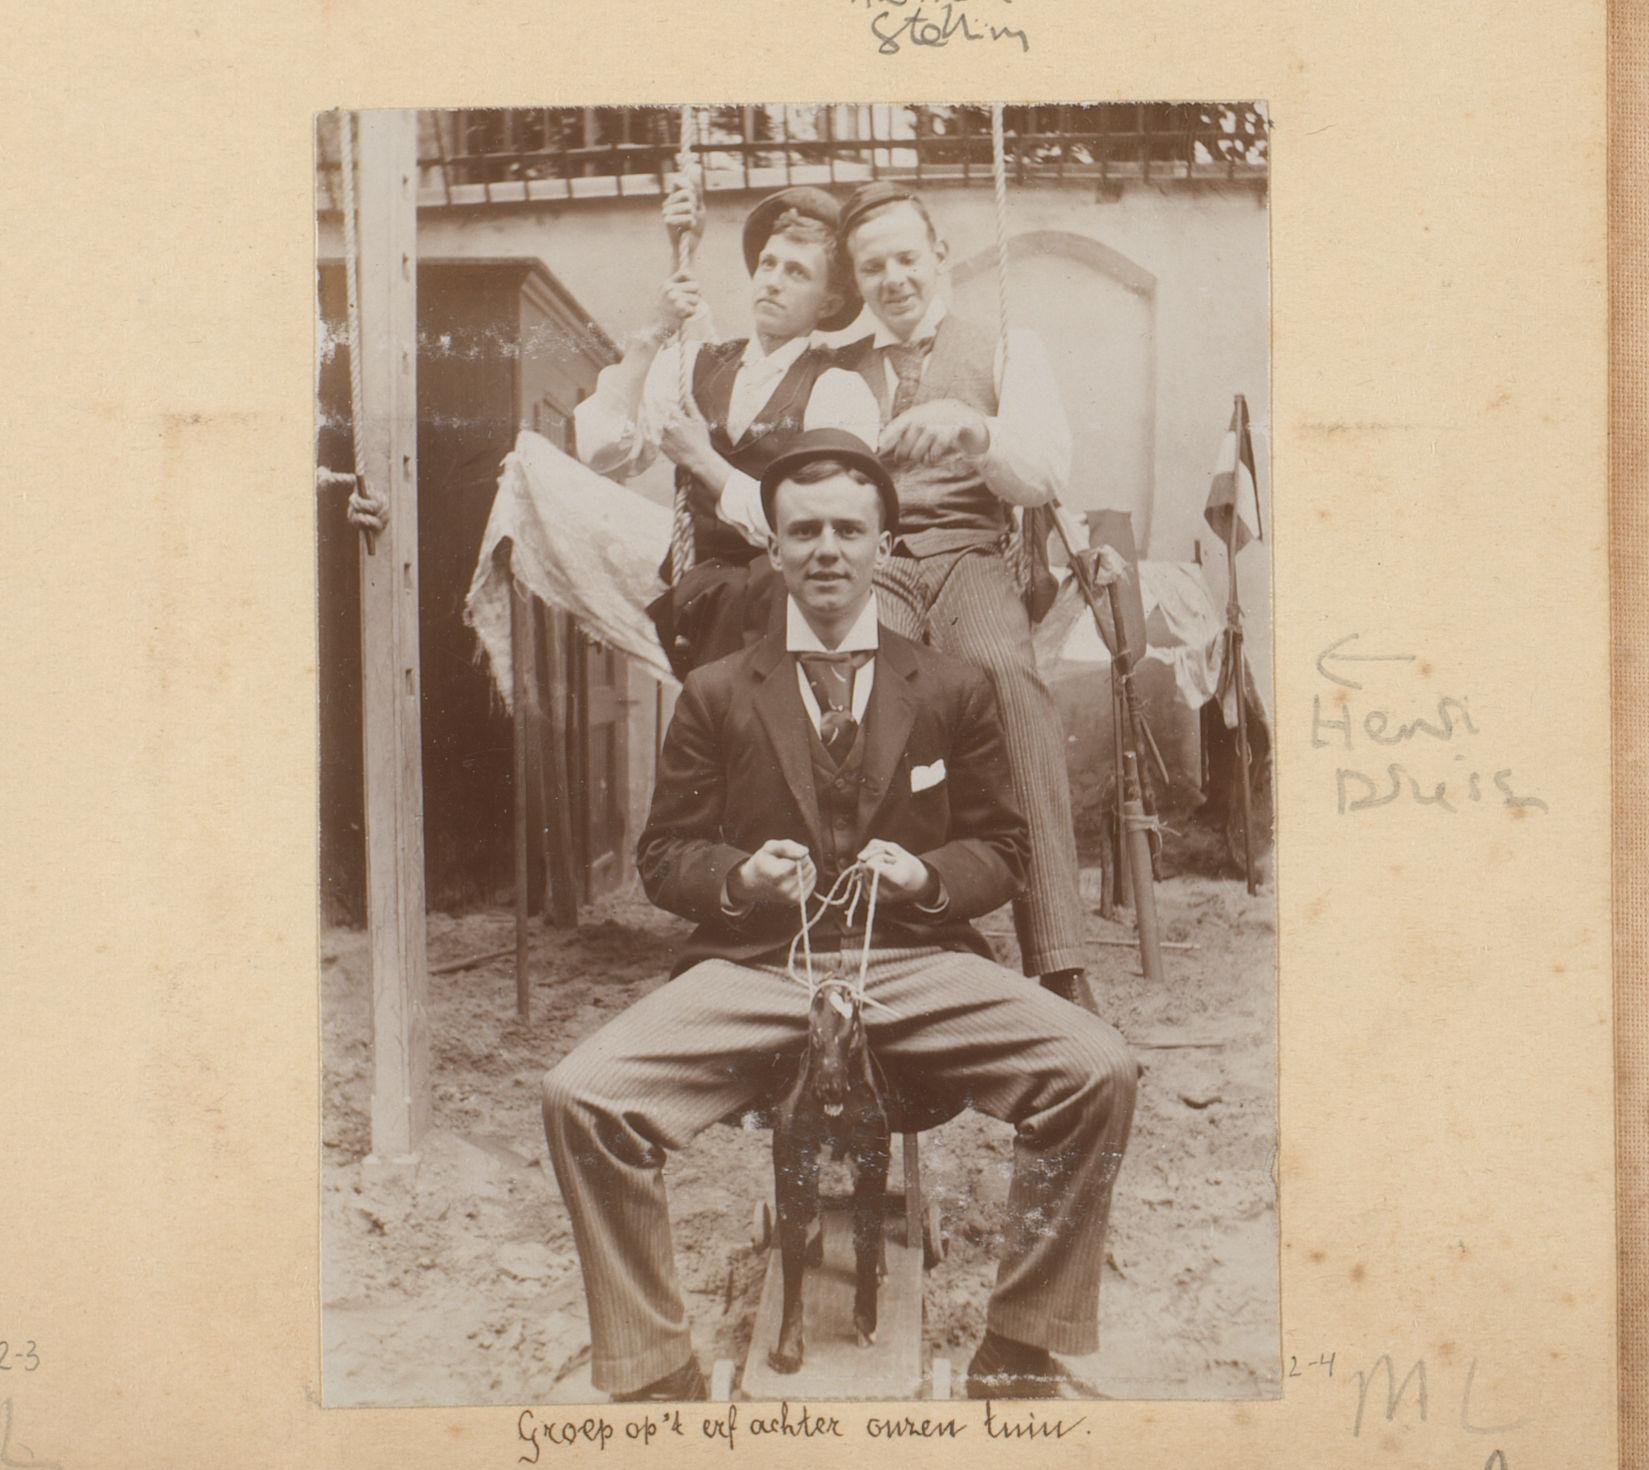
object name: photograph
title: Groep op 't erf achter onzen tuin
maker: hendrik herman van den berg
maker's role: amateurfotograaf, jurist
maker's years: 1875-1944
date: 1890-1894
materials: paper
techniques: collodion silver print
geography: amsterdam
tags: batavia, utrecht, historical persons, playground, amsterdam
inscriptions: caption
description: Foto 4 op albumblad 2 uit album "Amsterdam 1890-1894".